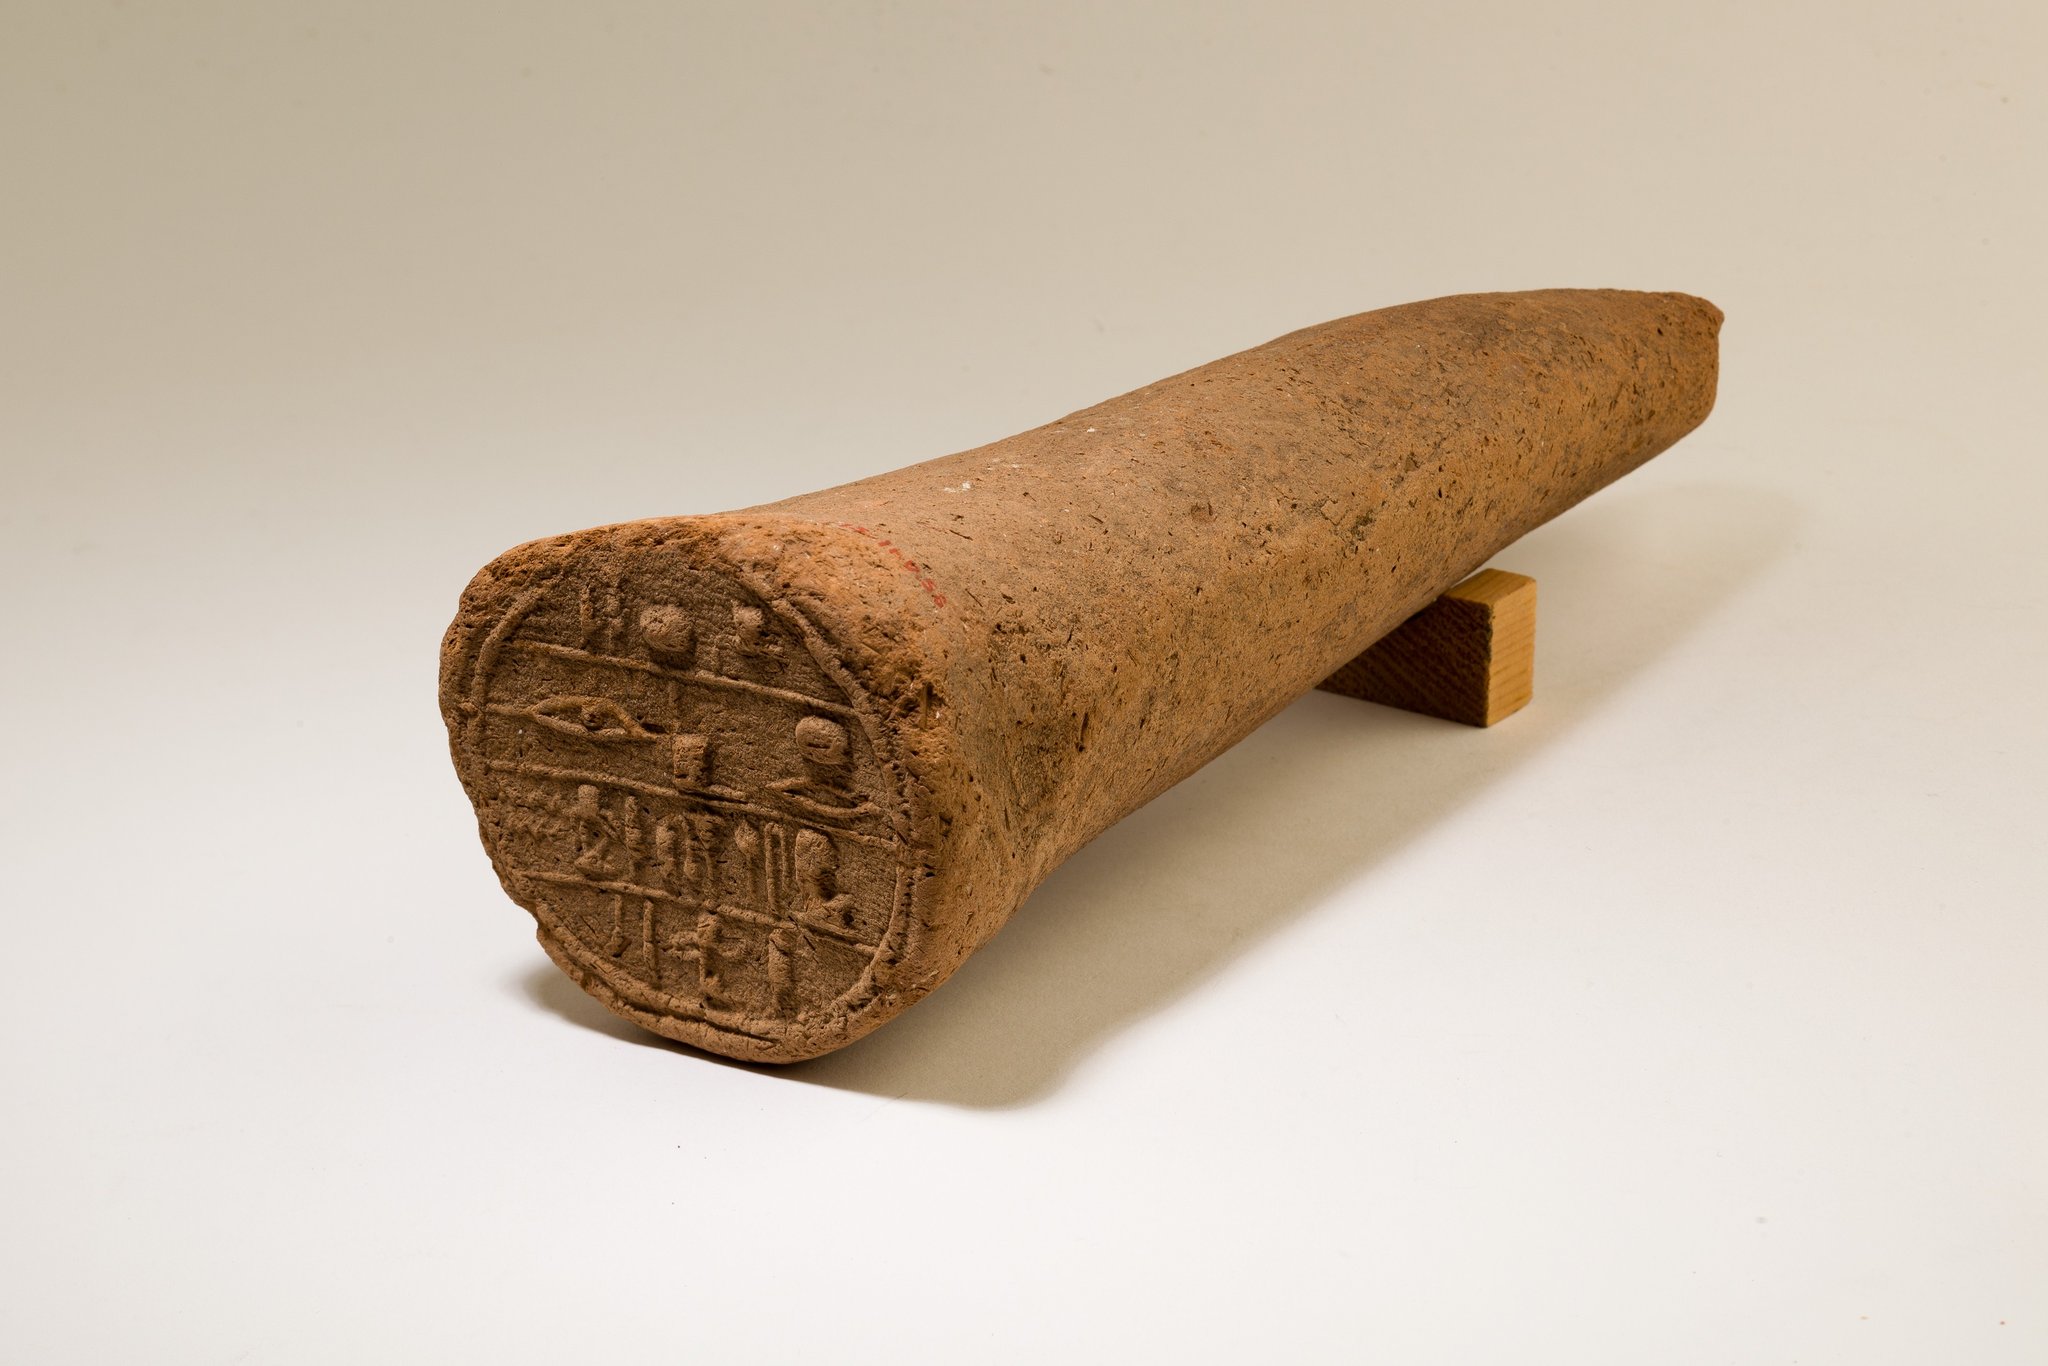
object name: cone, curcular impression, ineni, inspector of scribe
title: Funerary Cone of the Inspector of Scribes Ineni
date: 1550-1295 BCE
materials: pottery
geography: egypt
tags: hieroglyphs